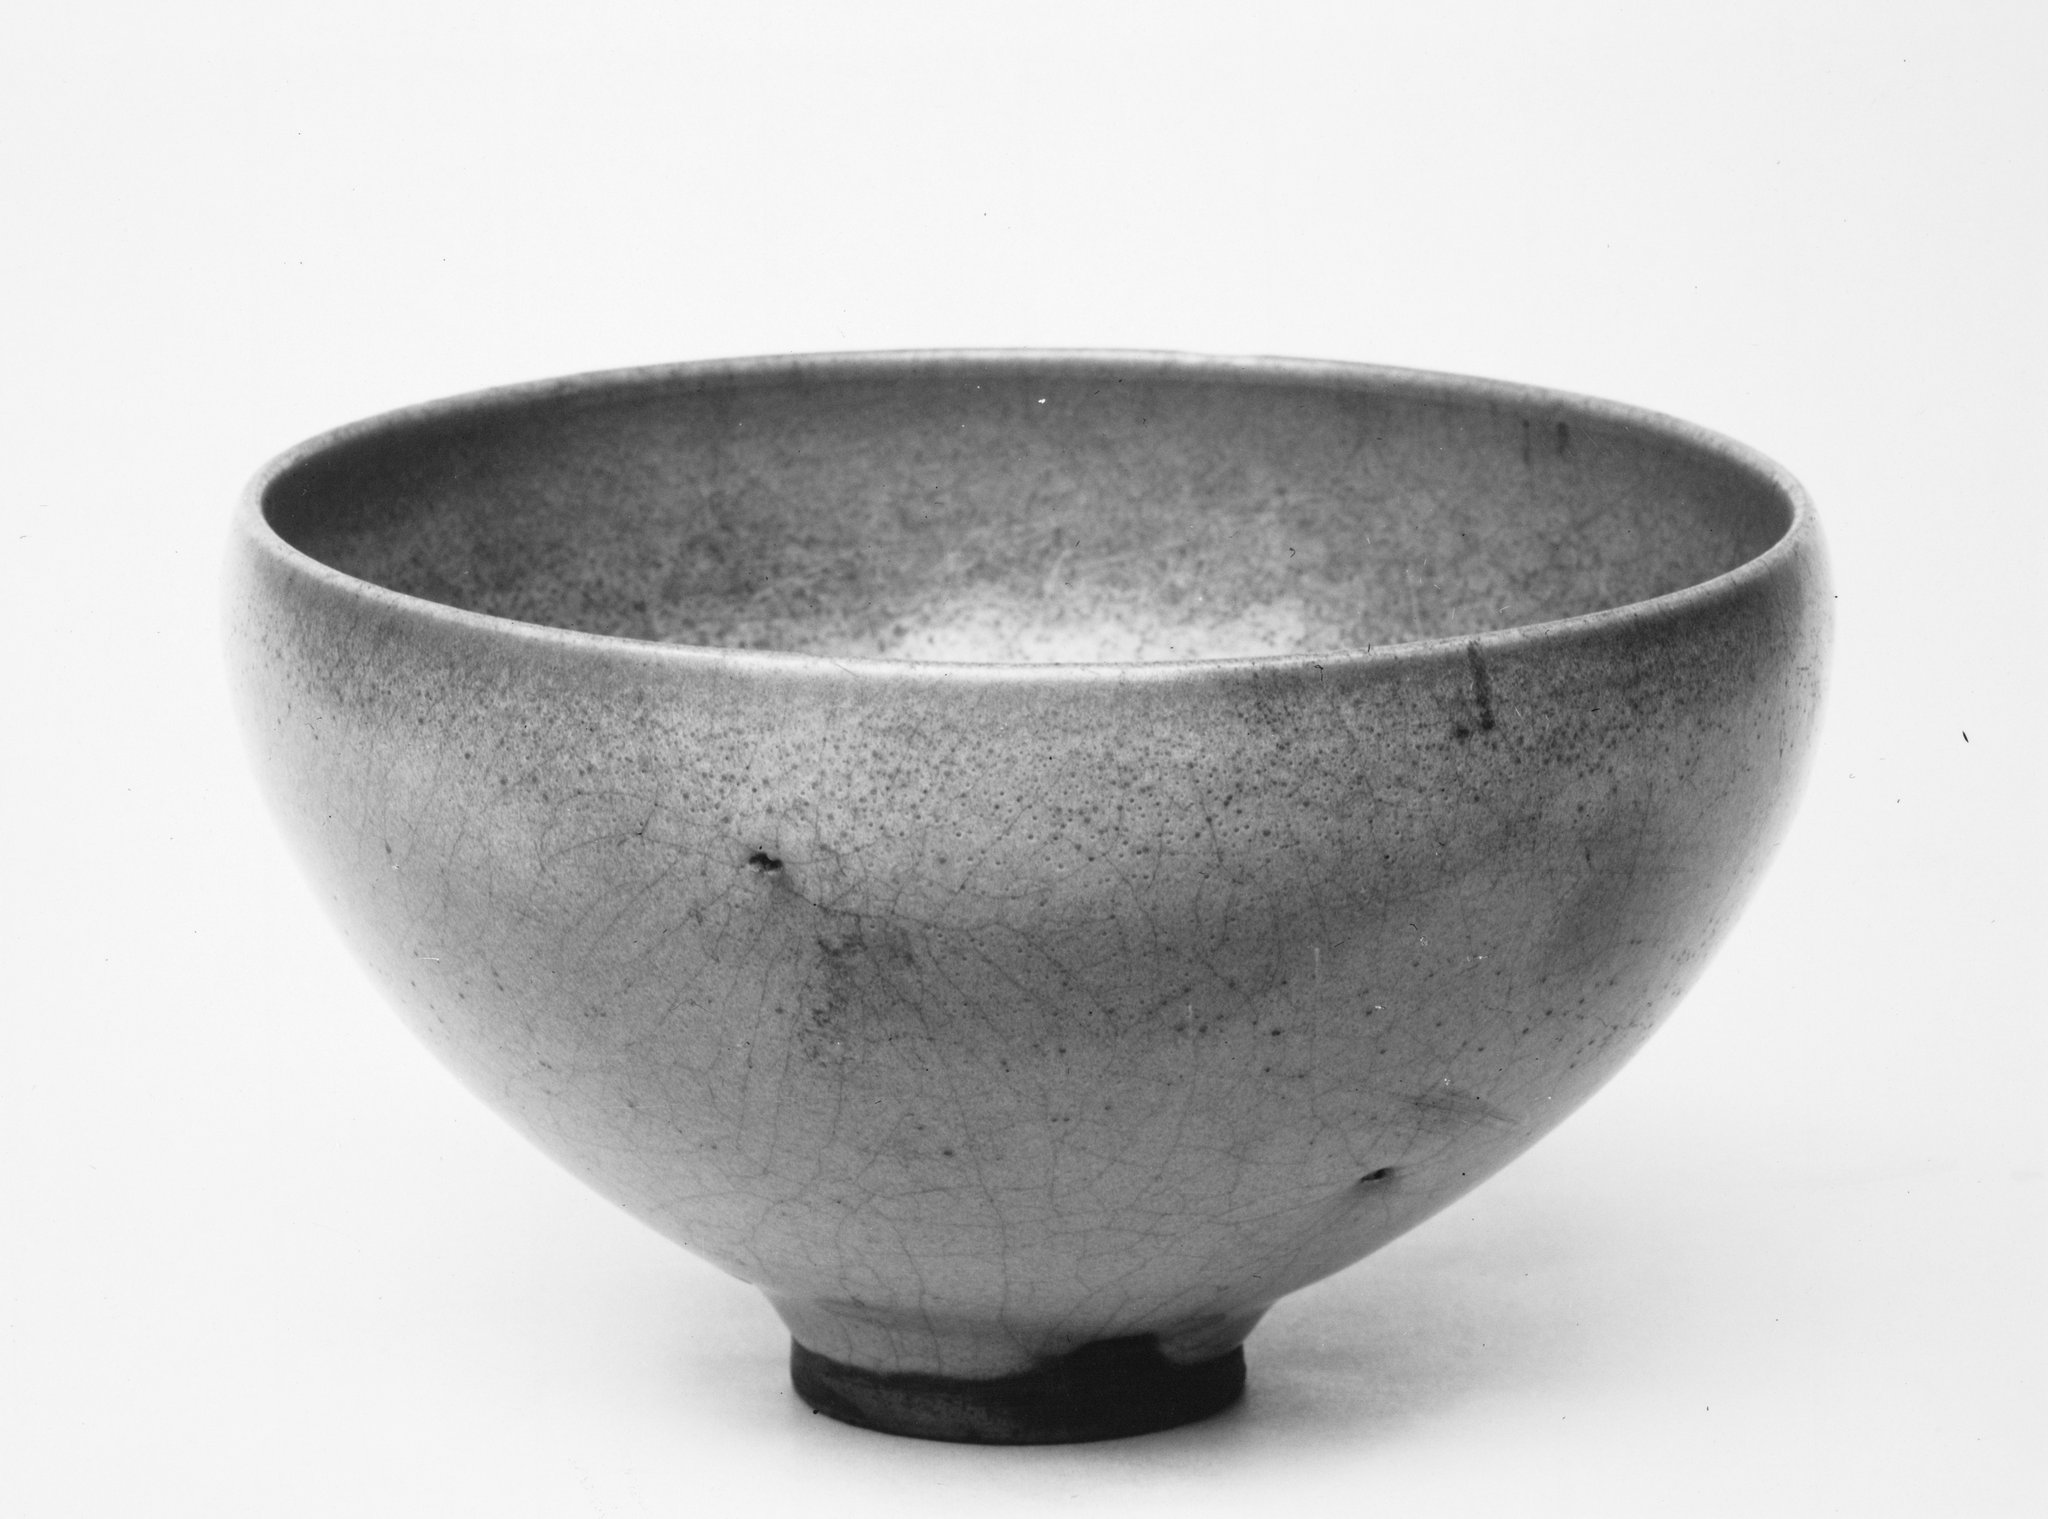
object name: bowl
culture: chinese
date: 1271-1368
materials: glaze, stoneware